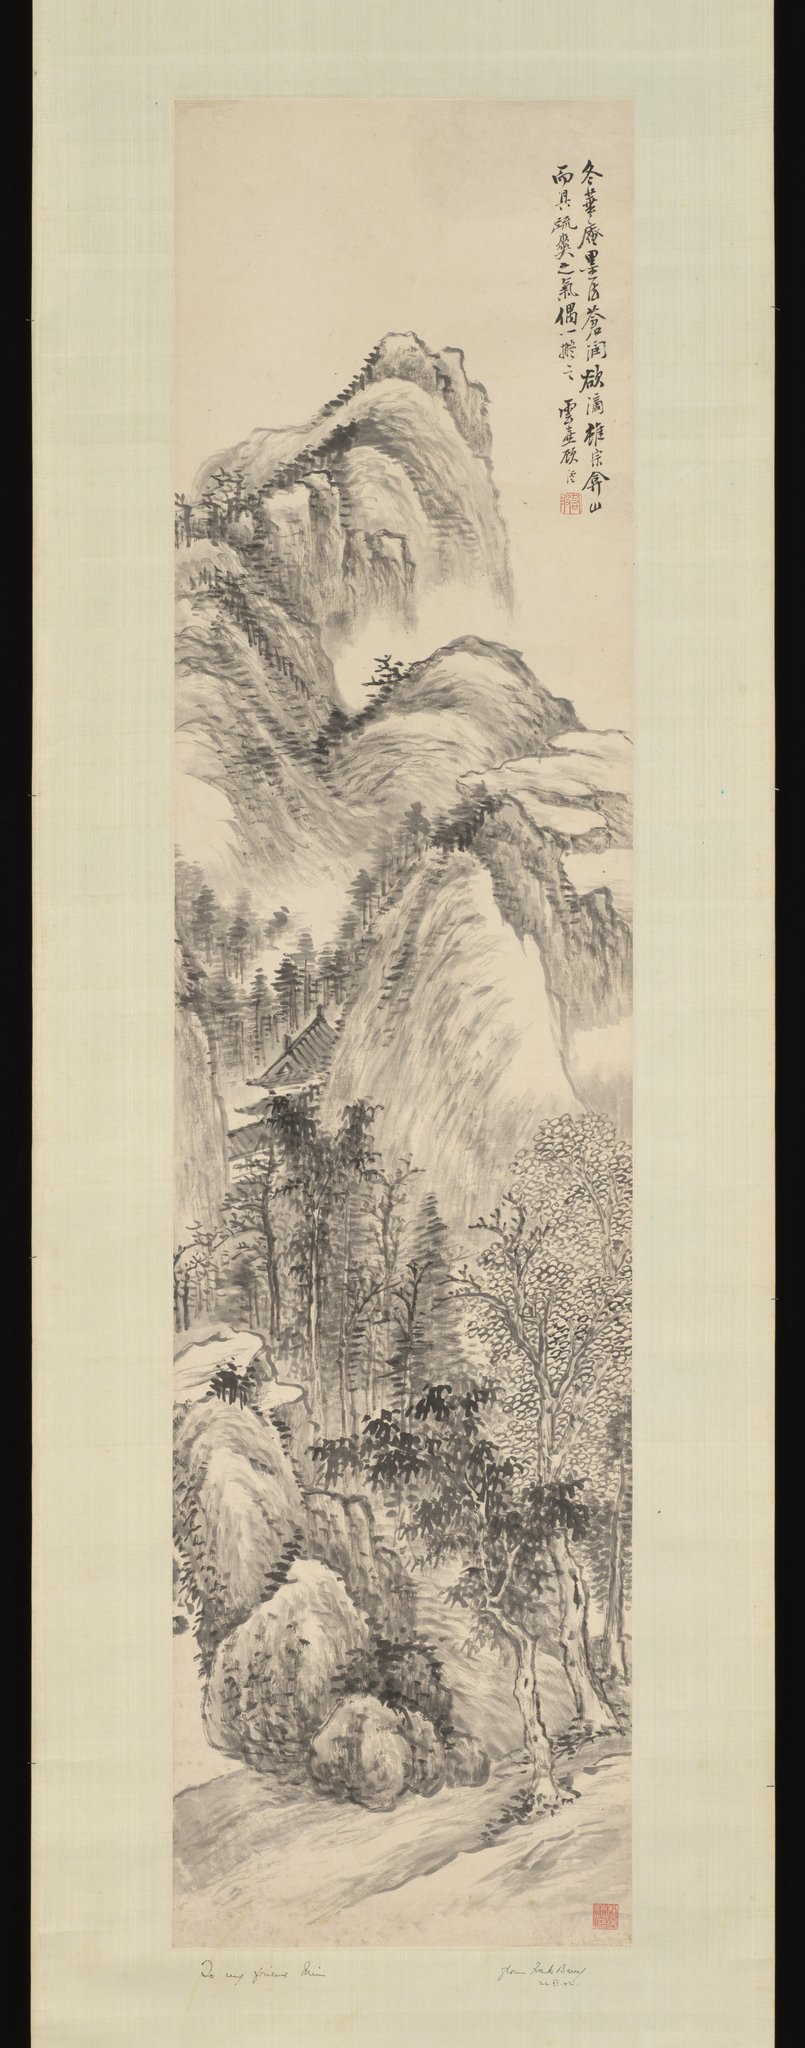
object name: hanging scroll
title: Landscape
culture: chinese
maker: gu yun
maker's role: artist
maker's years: 1835-1896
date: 1835-1896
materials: ink, paper